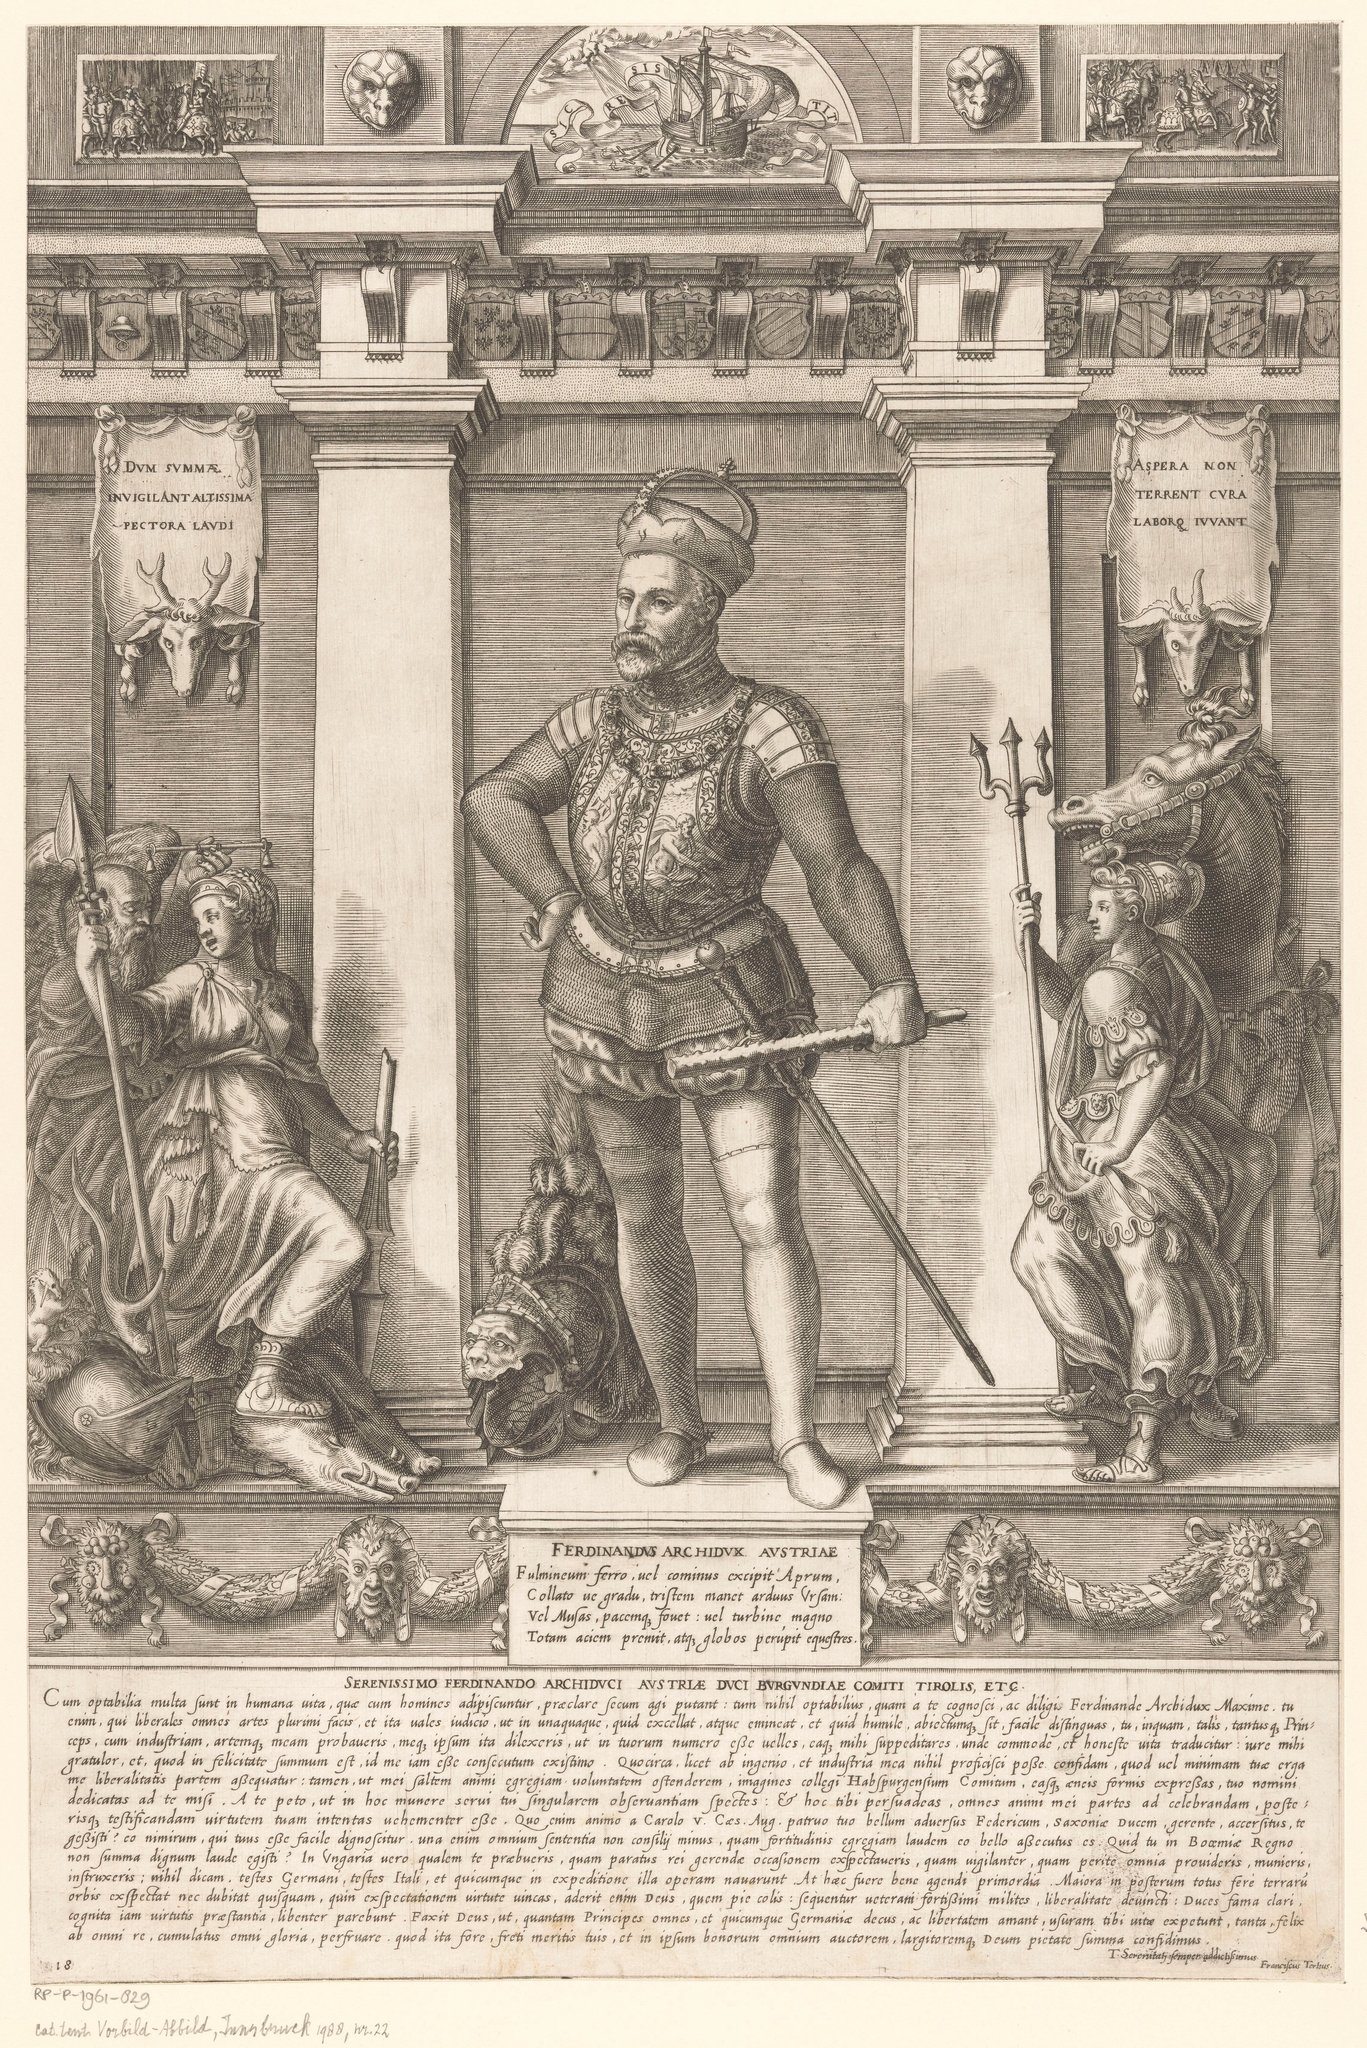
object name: print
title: Austriacae gentis imaginum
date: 1569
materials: paper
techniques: engraving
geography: italy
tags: ferdinand ii van tirol, historical persons, ruler, sovereign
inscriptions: collector's mark: Lugt 2228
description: Deze prent maakt deel uit van een reeks van 58 prenten. Het meerendeel van de prenten bevat portretten van 74 leden van het Oostenrijkse Huis, naar tekeningen door Francesco Terzio, die deels getekend zijn naar de 28 levensgrote bronzen beelden die rond de cenotaaf van Maximiliaan I in de Hofkirche te Innsbruck staan.